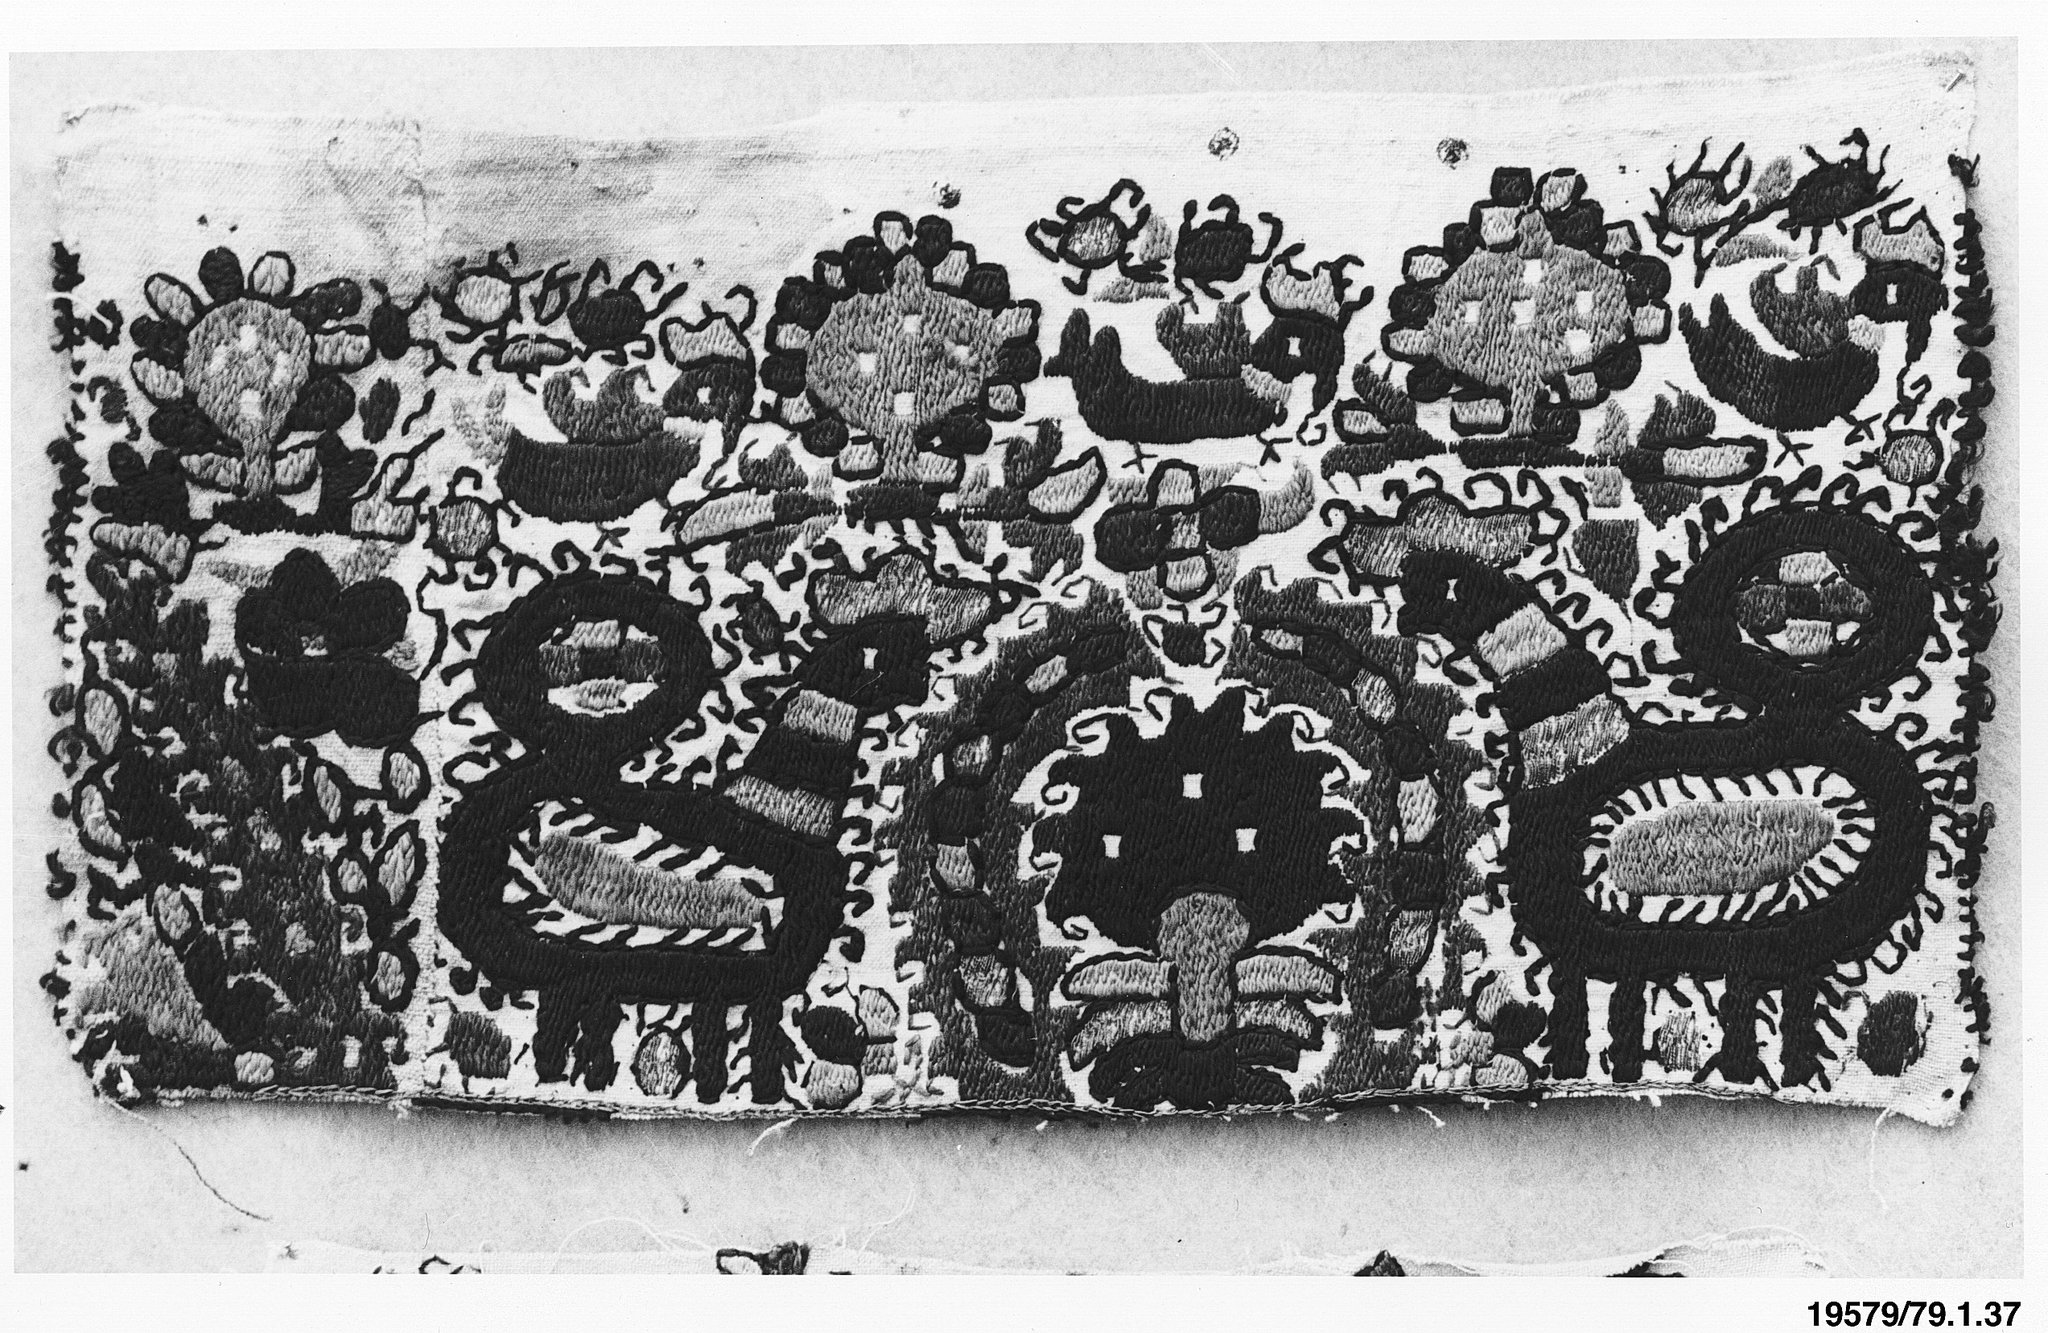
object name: fragment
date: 1801-1833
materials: linen, metal thread, silk